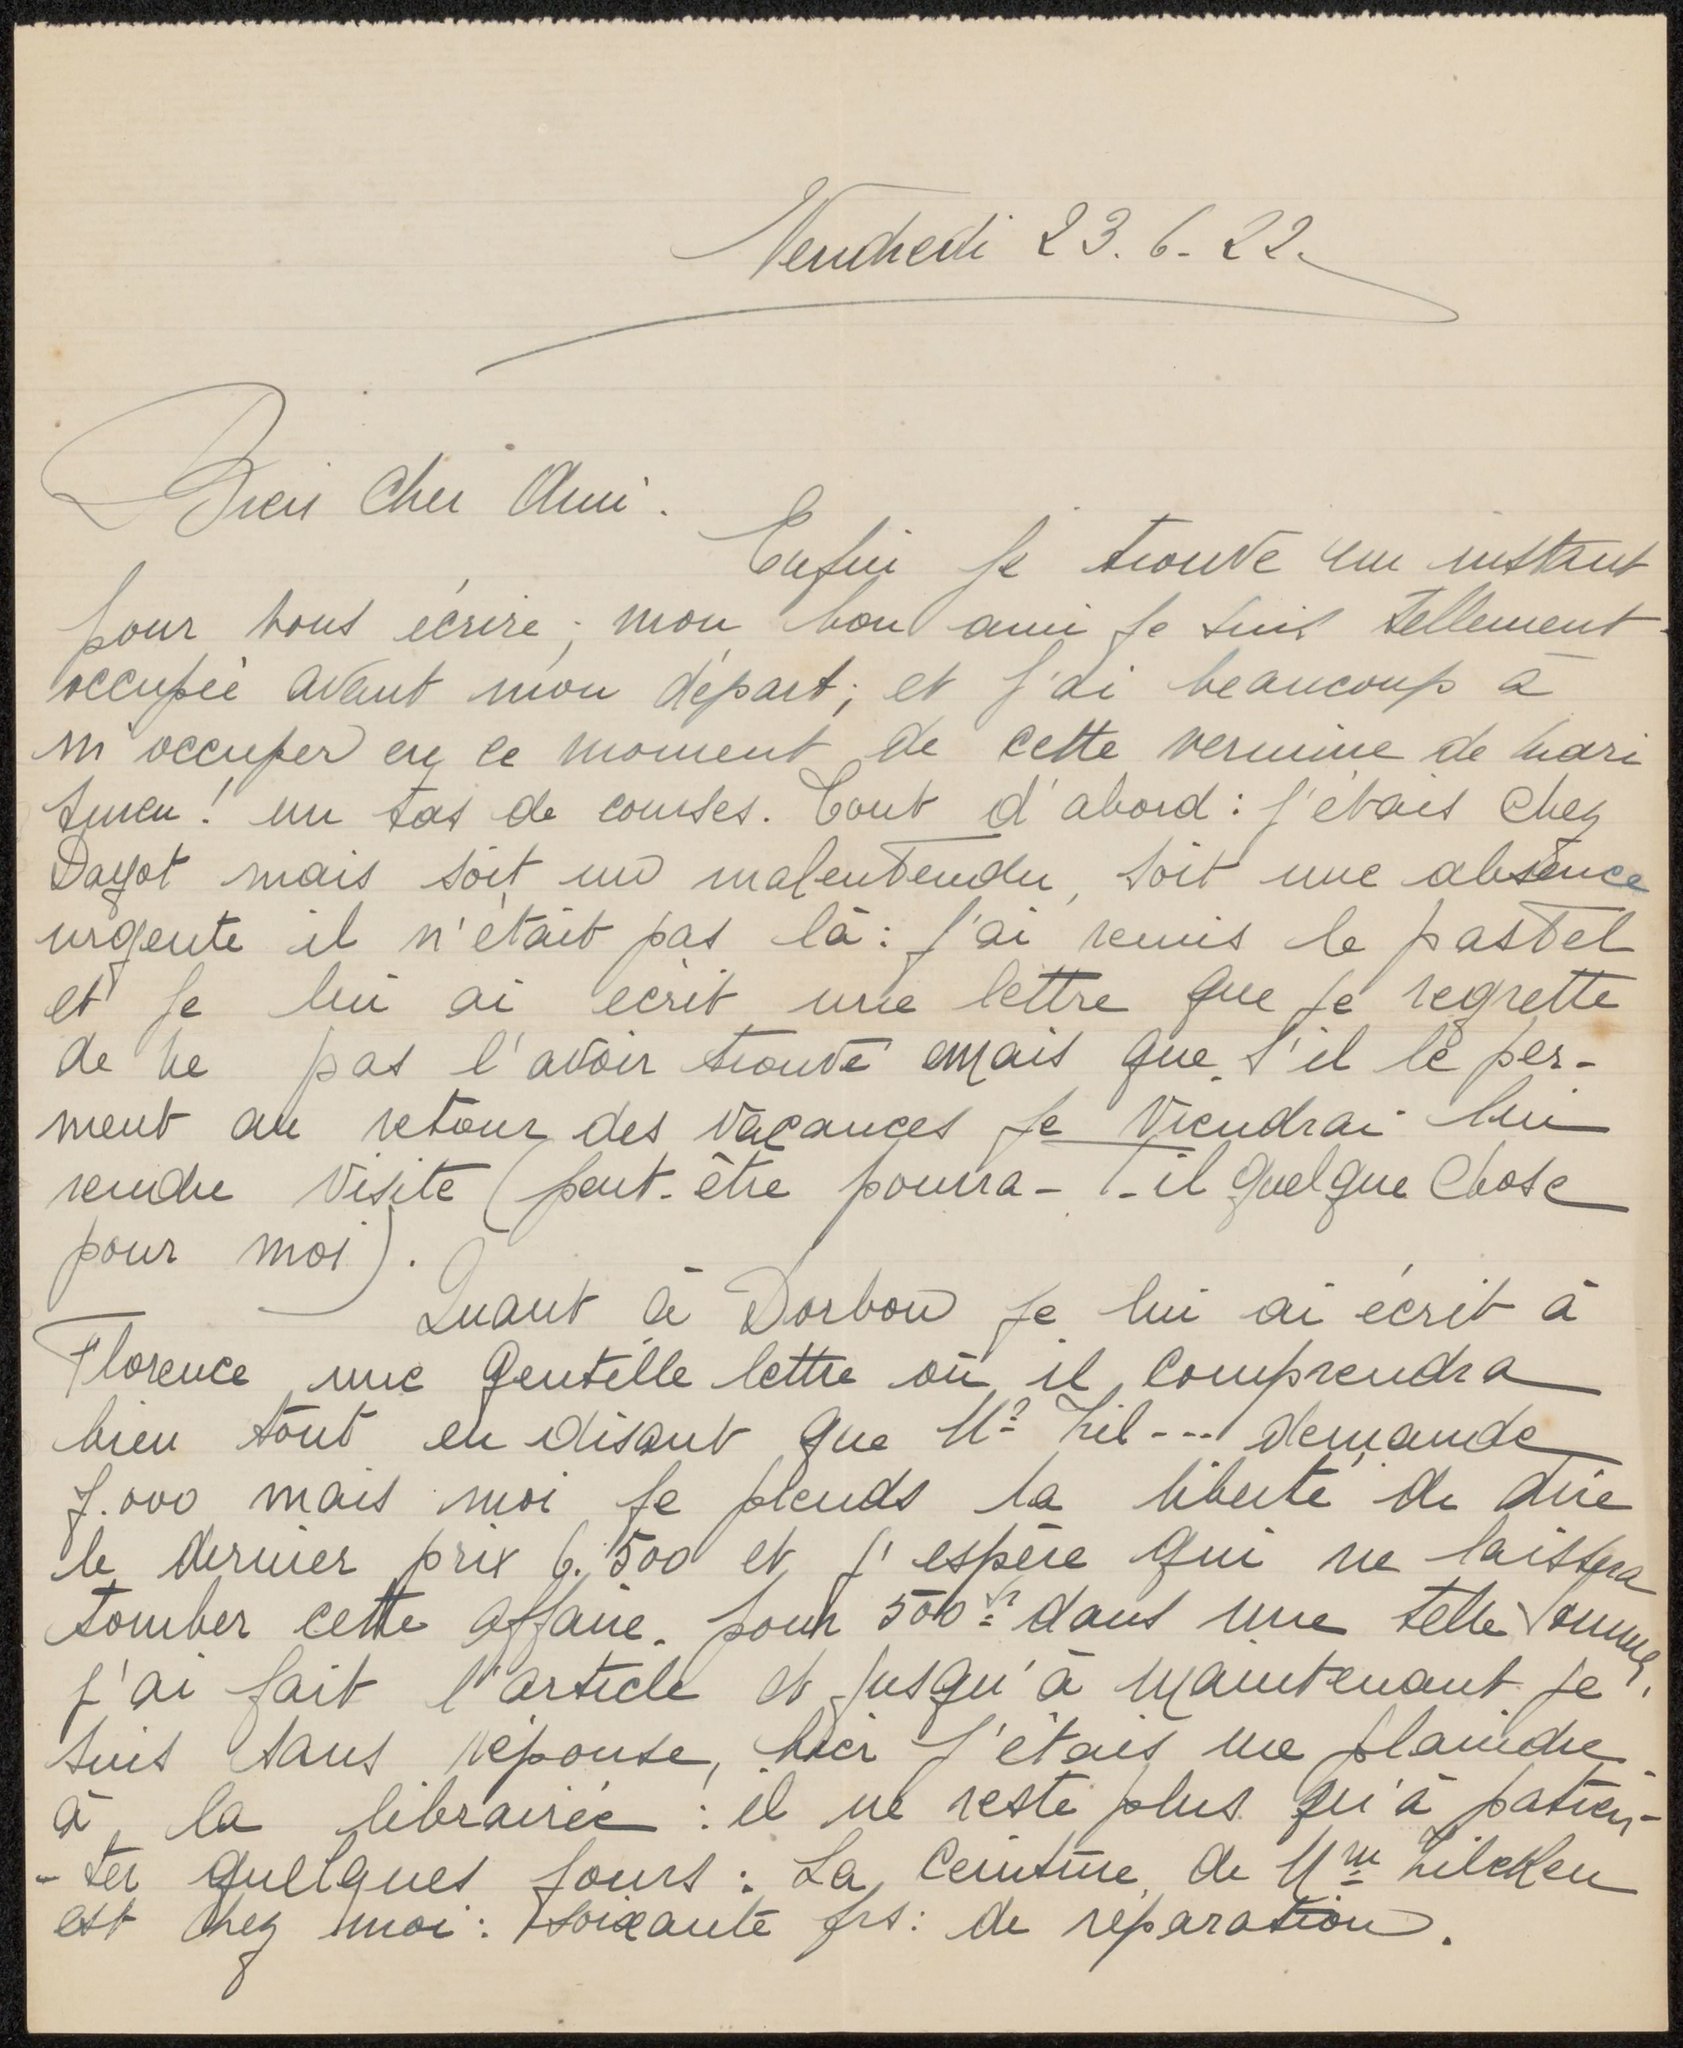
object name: letter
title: Brief aan Philip Zilcken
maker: rose imel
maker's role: draughtsman, painter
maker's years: 1901-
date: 1922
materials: ink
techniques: pen, writing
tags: publisher, painter, draughtsman, philip zilcken, exhibition ~ art, money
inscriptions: collector's mark: ‘RPK’